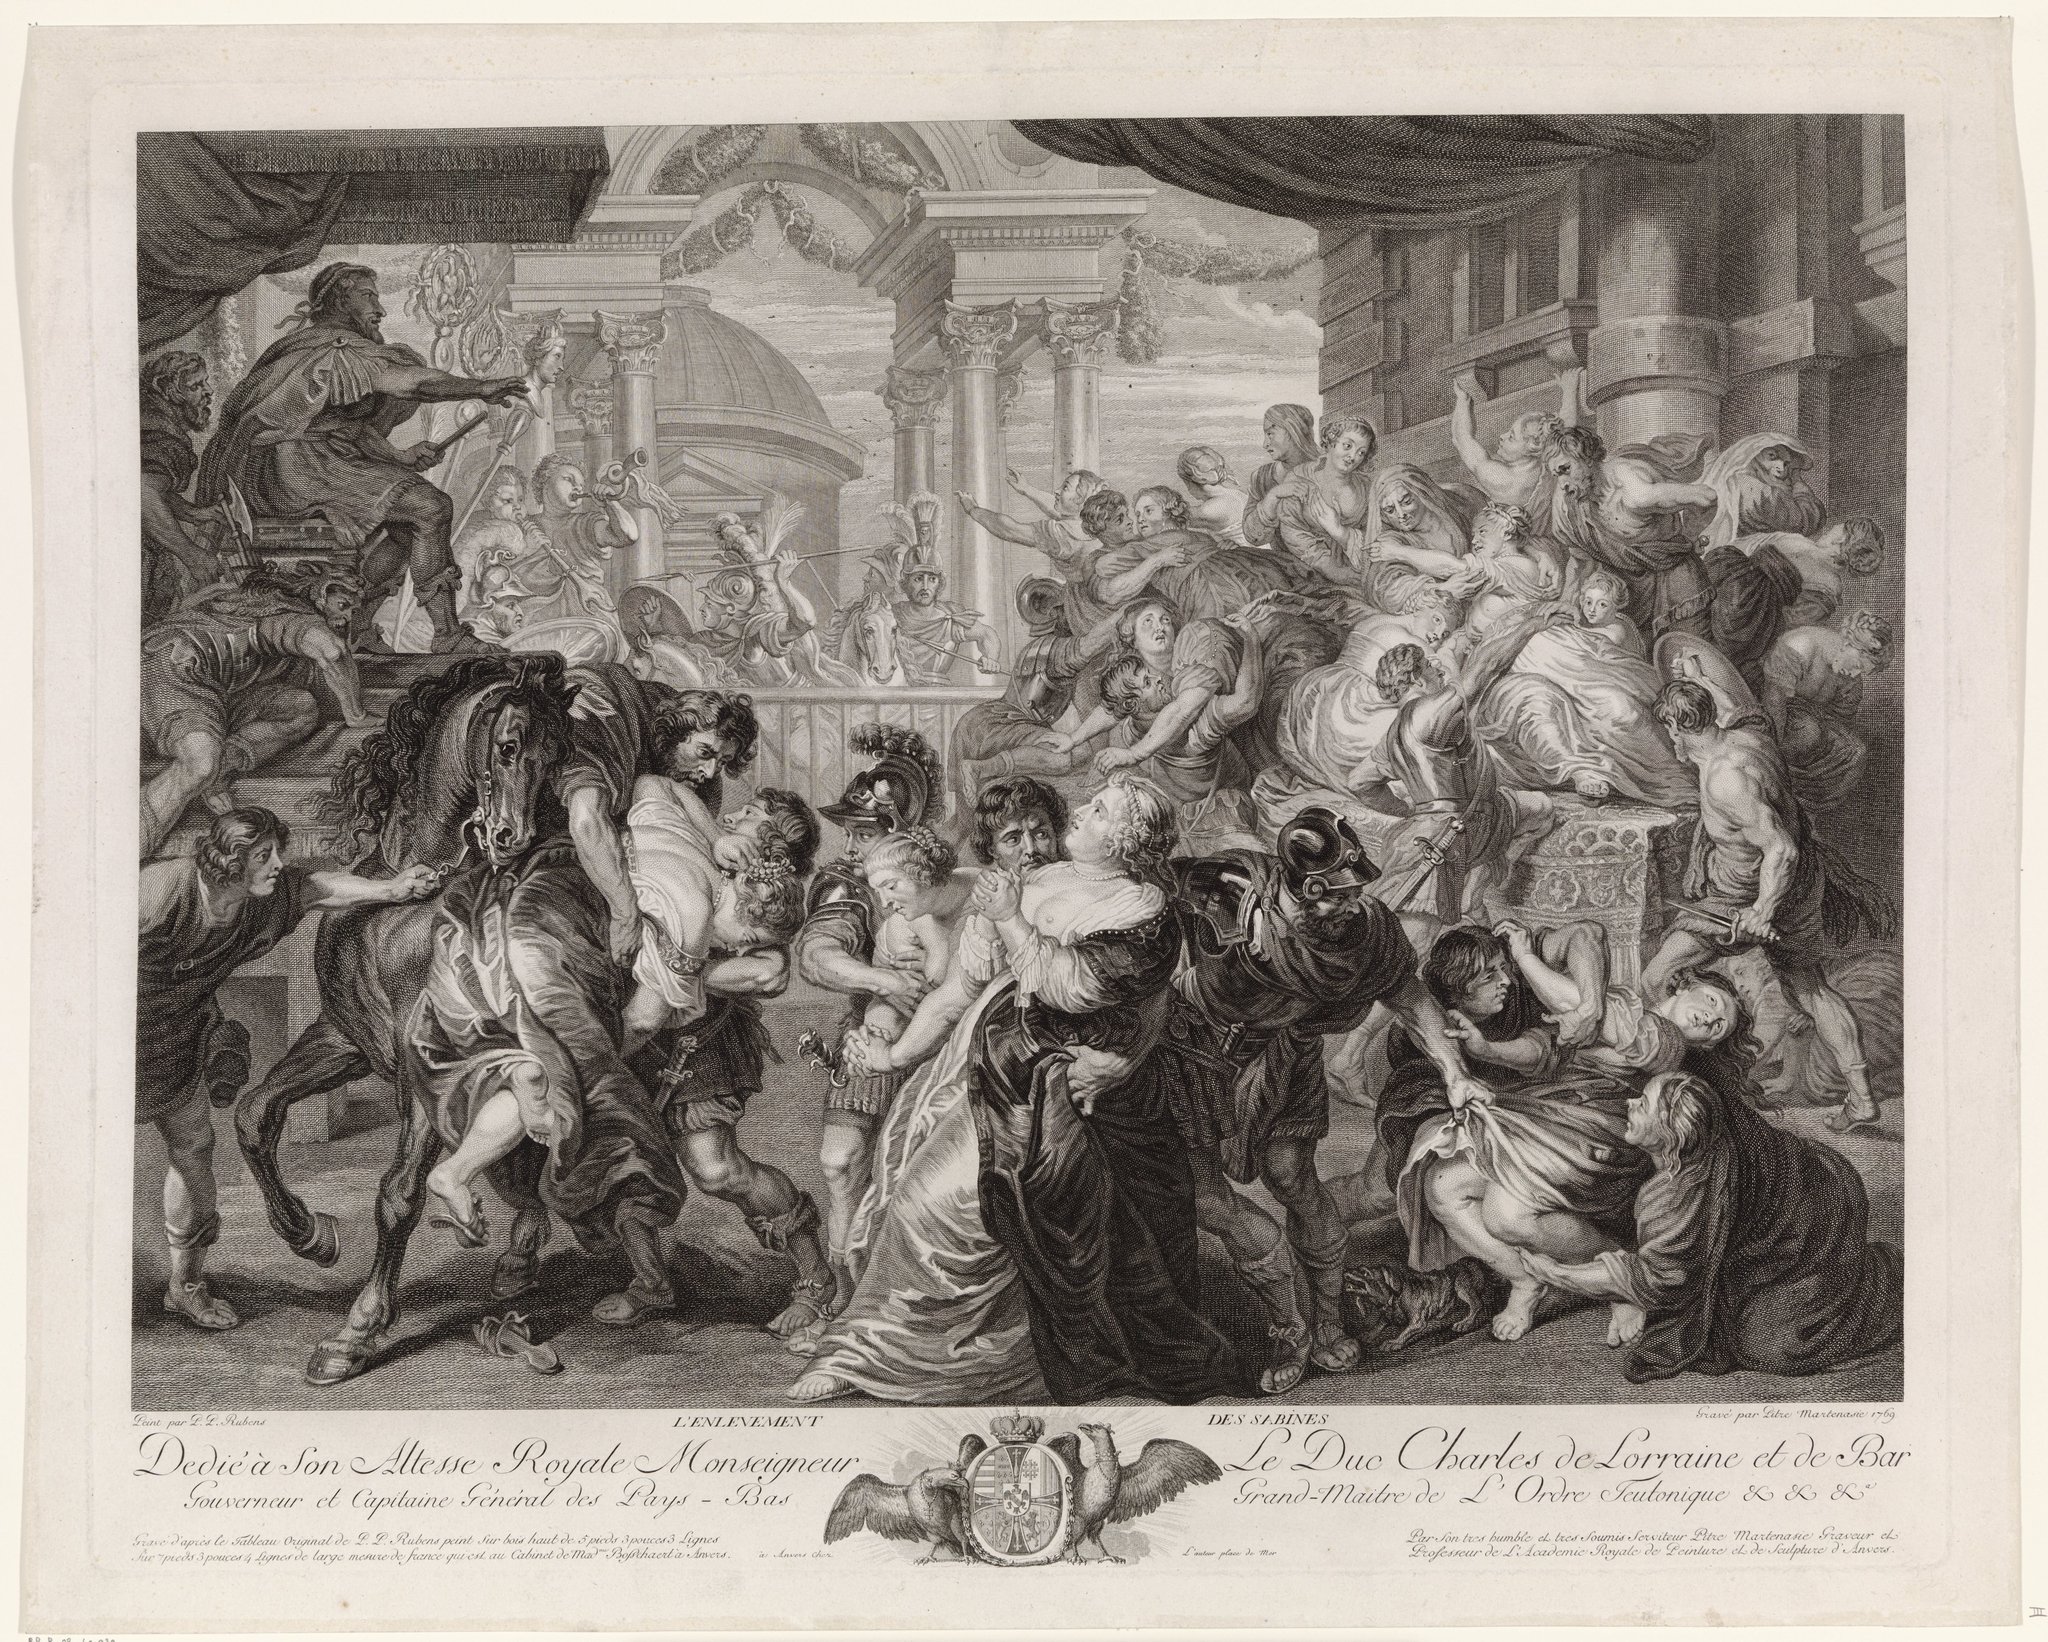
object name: print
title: Sabijnse maagdenroof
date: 1769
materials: paper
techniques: engraving, etching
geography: antwerp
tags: rape of the sabine women: they are carried off by romulus and his men during a feast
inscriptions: date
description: Romulus, links onder een baldakijn, geeft opdracht de dochters van de Sabijnen te roven.